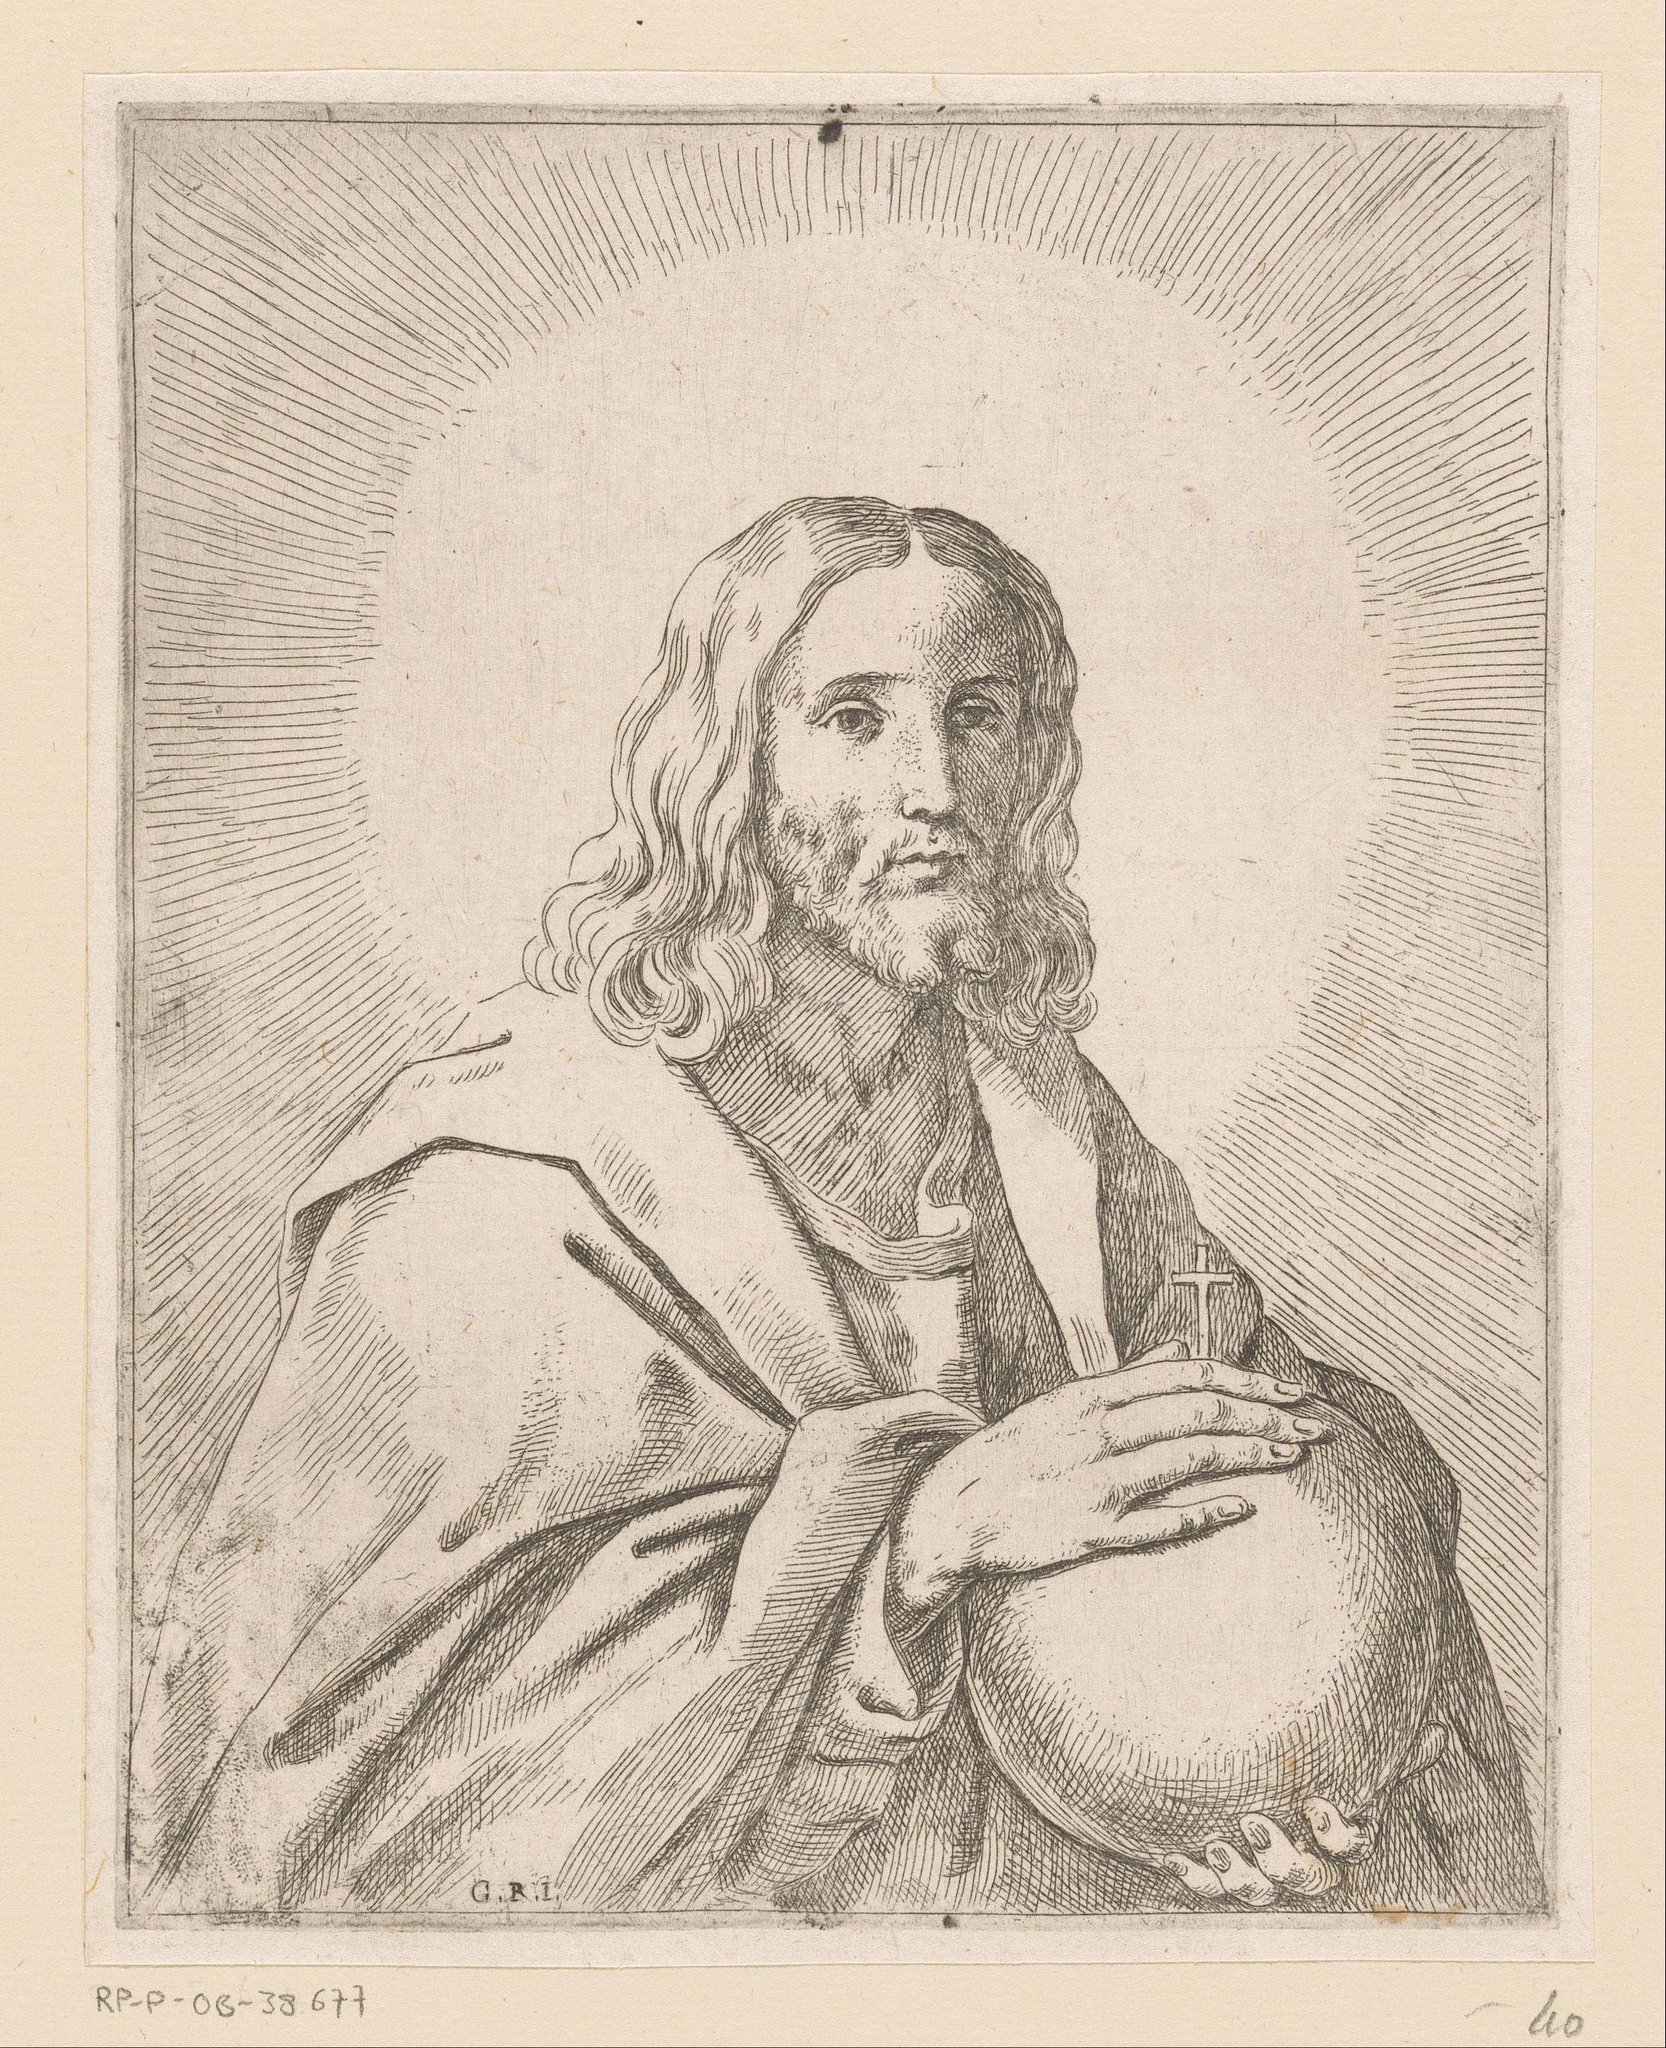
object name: print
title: Christus met rijksappel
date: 1585-1692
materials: paper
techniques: etching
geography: italy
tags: orb (symbol of sovereignty; sphere with cross on top), particular types of adult christ (without others)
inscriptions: collector's mark: Lugt 240